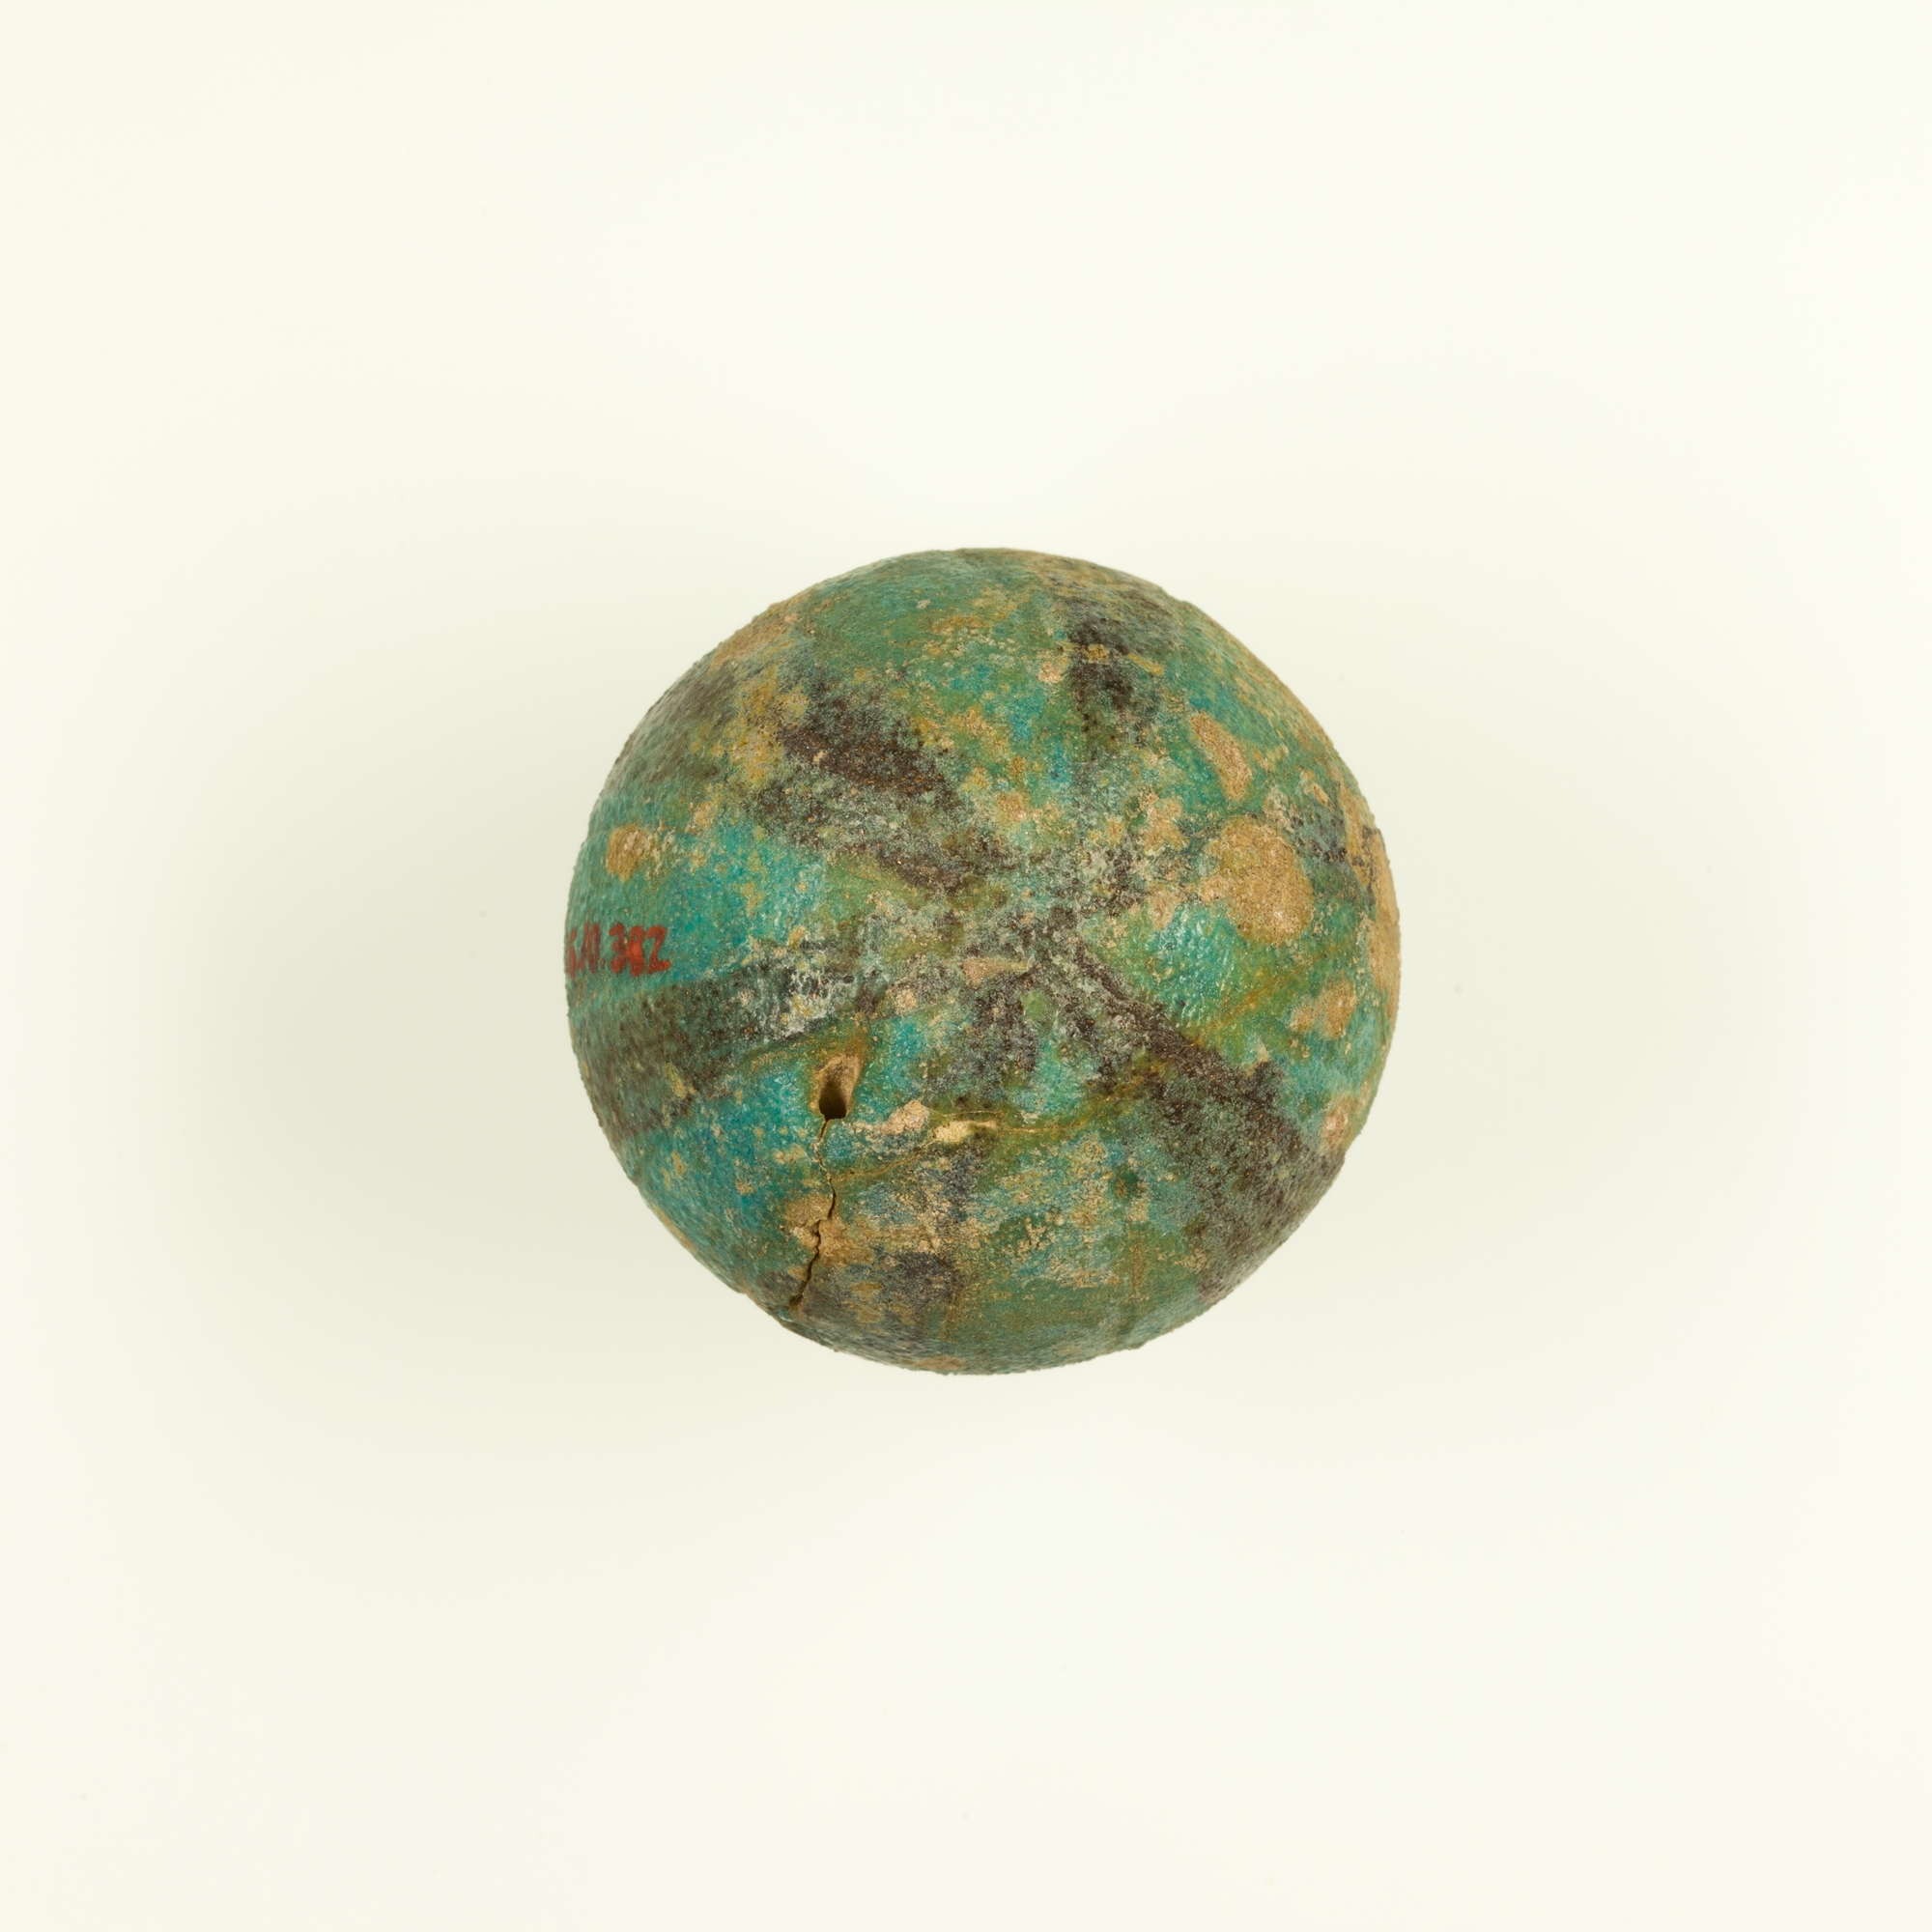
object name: bead, ball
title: Large Ball Bead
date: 1981-1458 BCE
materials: faience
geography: egypt